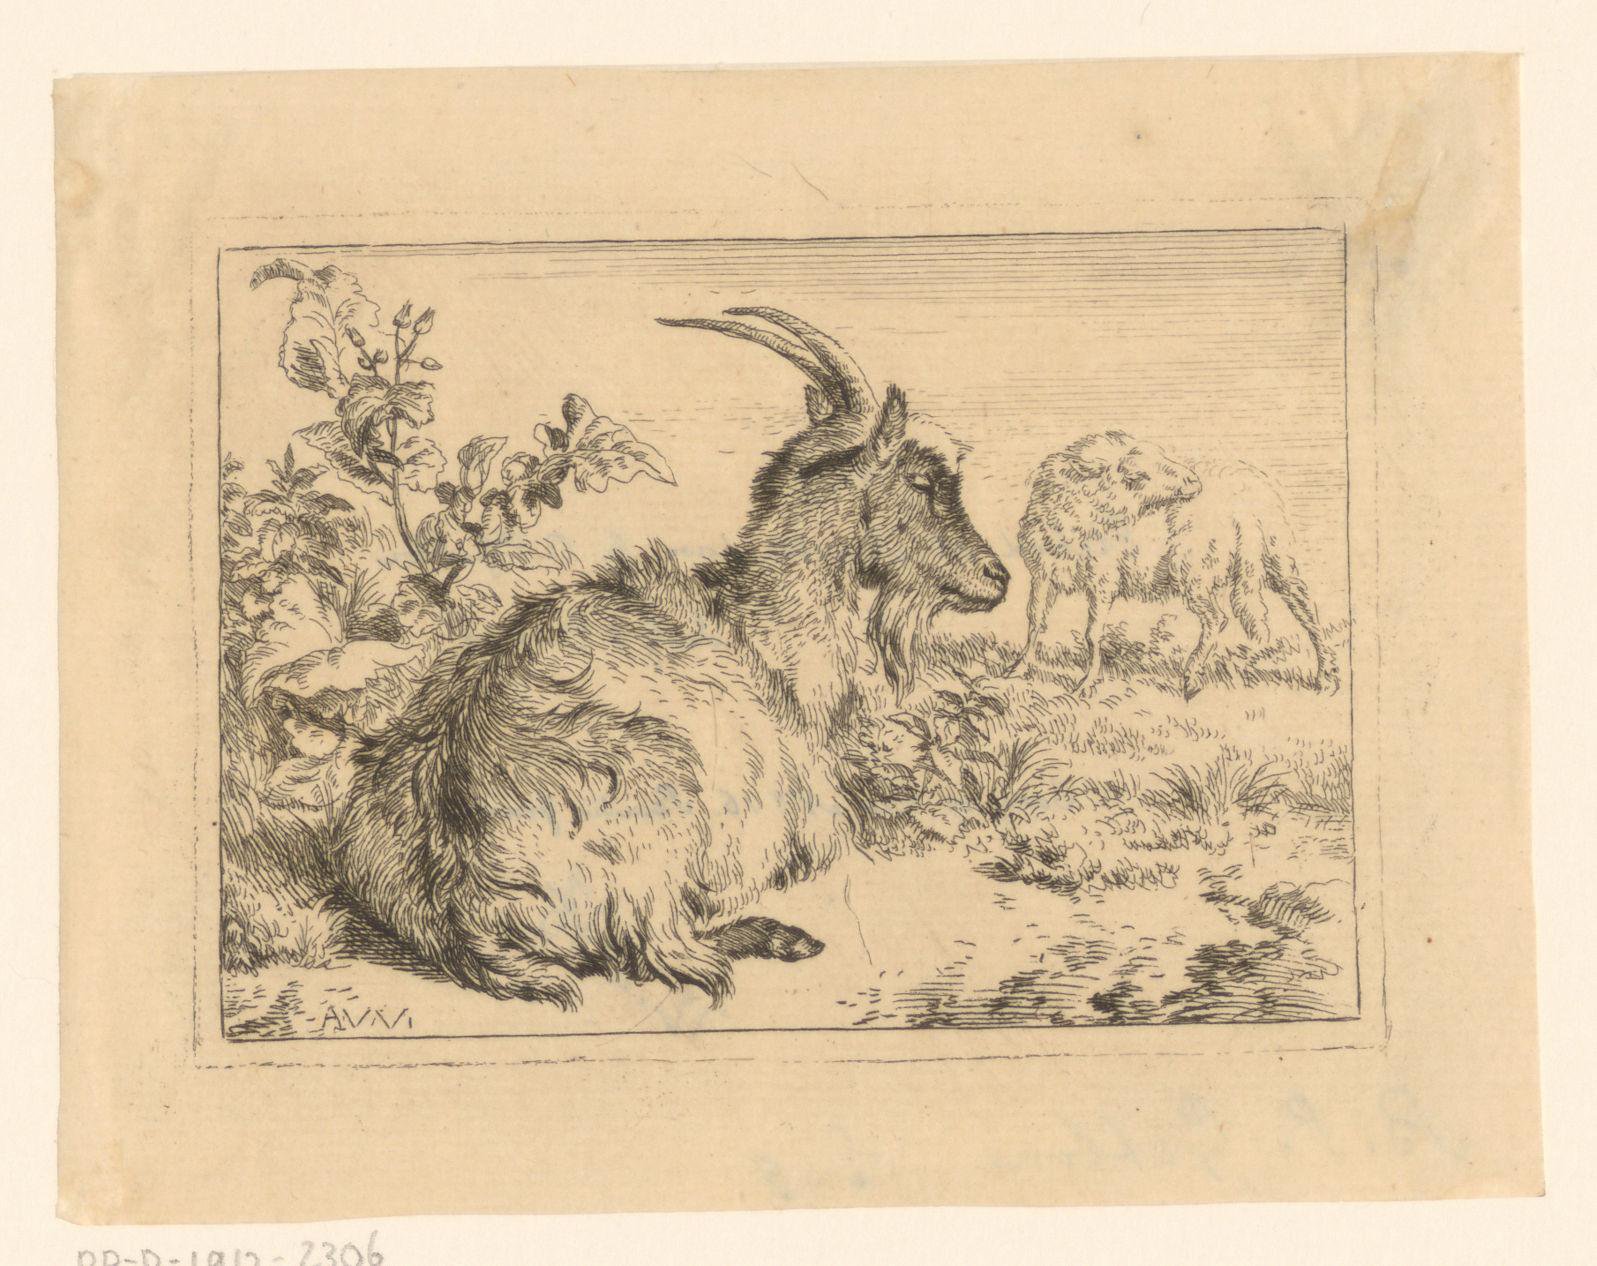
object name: print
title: Liggende geit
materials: paper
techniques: etching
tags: goat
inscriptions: annotation: ‘Copy/ Etched at Amsterdam by B. P. Gibbon/ July 5th 1830’, collector's mark: Lugt 2228